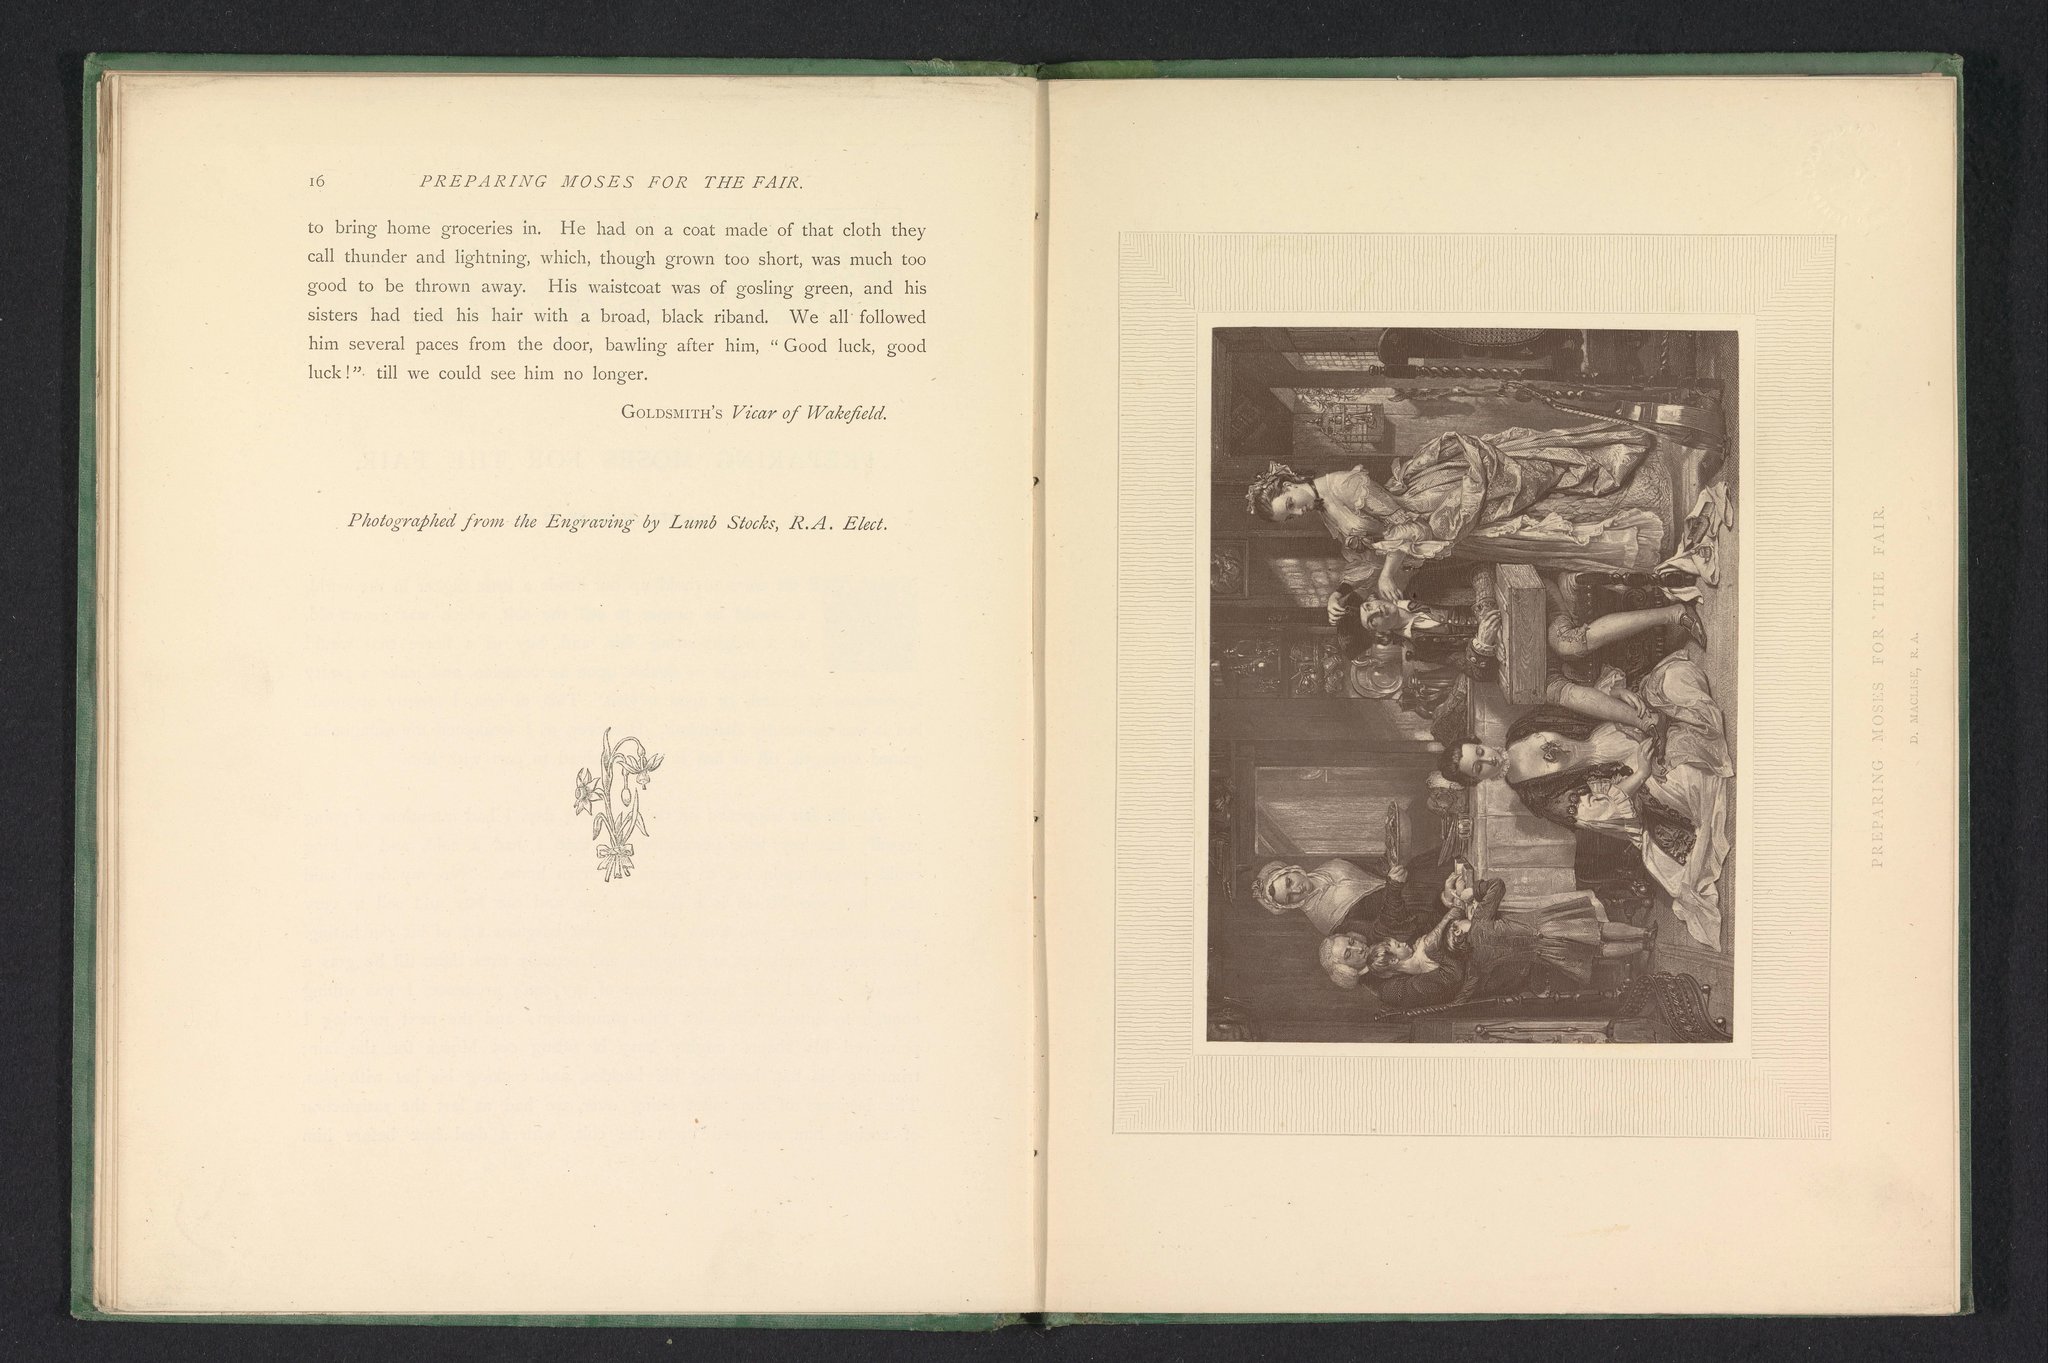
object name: reproduction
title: Preparing Moses for the fair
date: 1863-1873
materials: paper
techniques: woodburytype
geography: london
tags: making up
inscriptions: name: ‘Essex [...]’